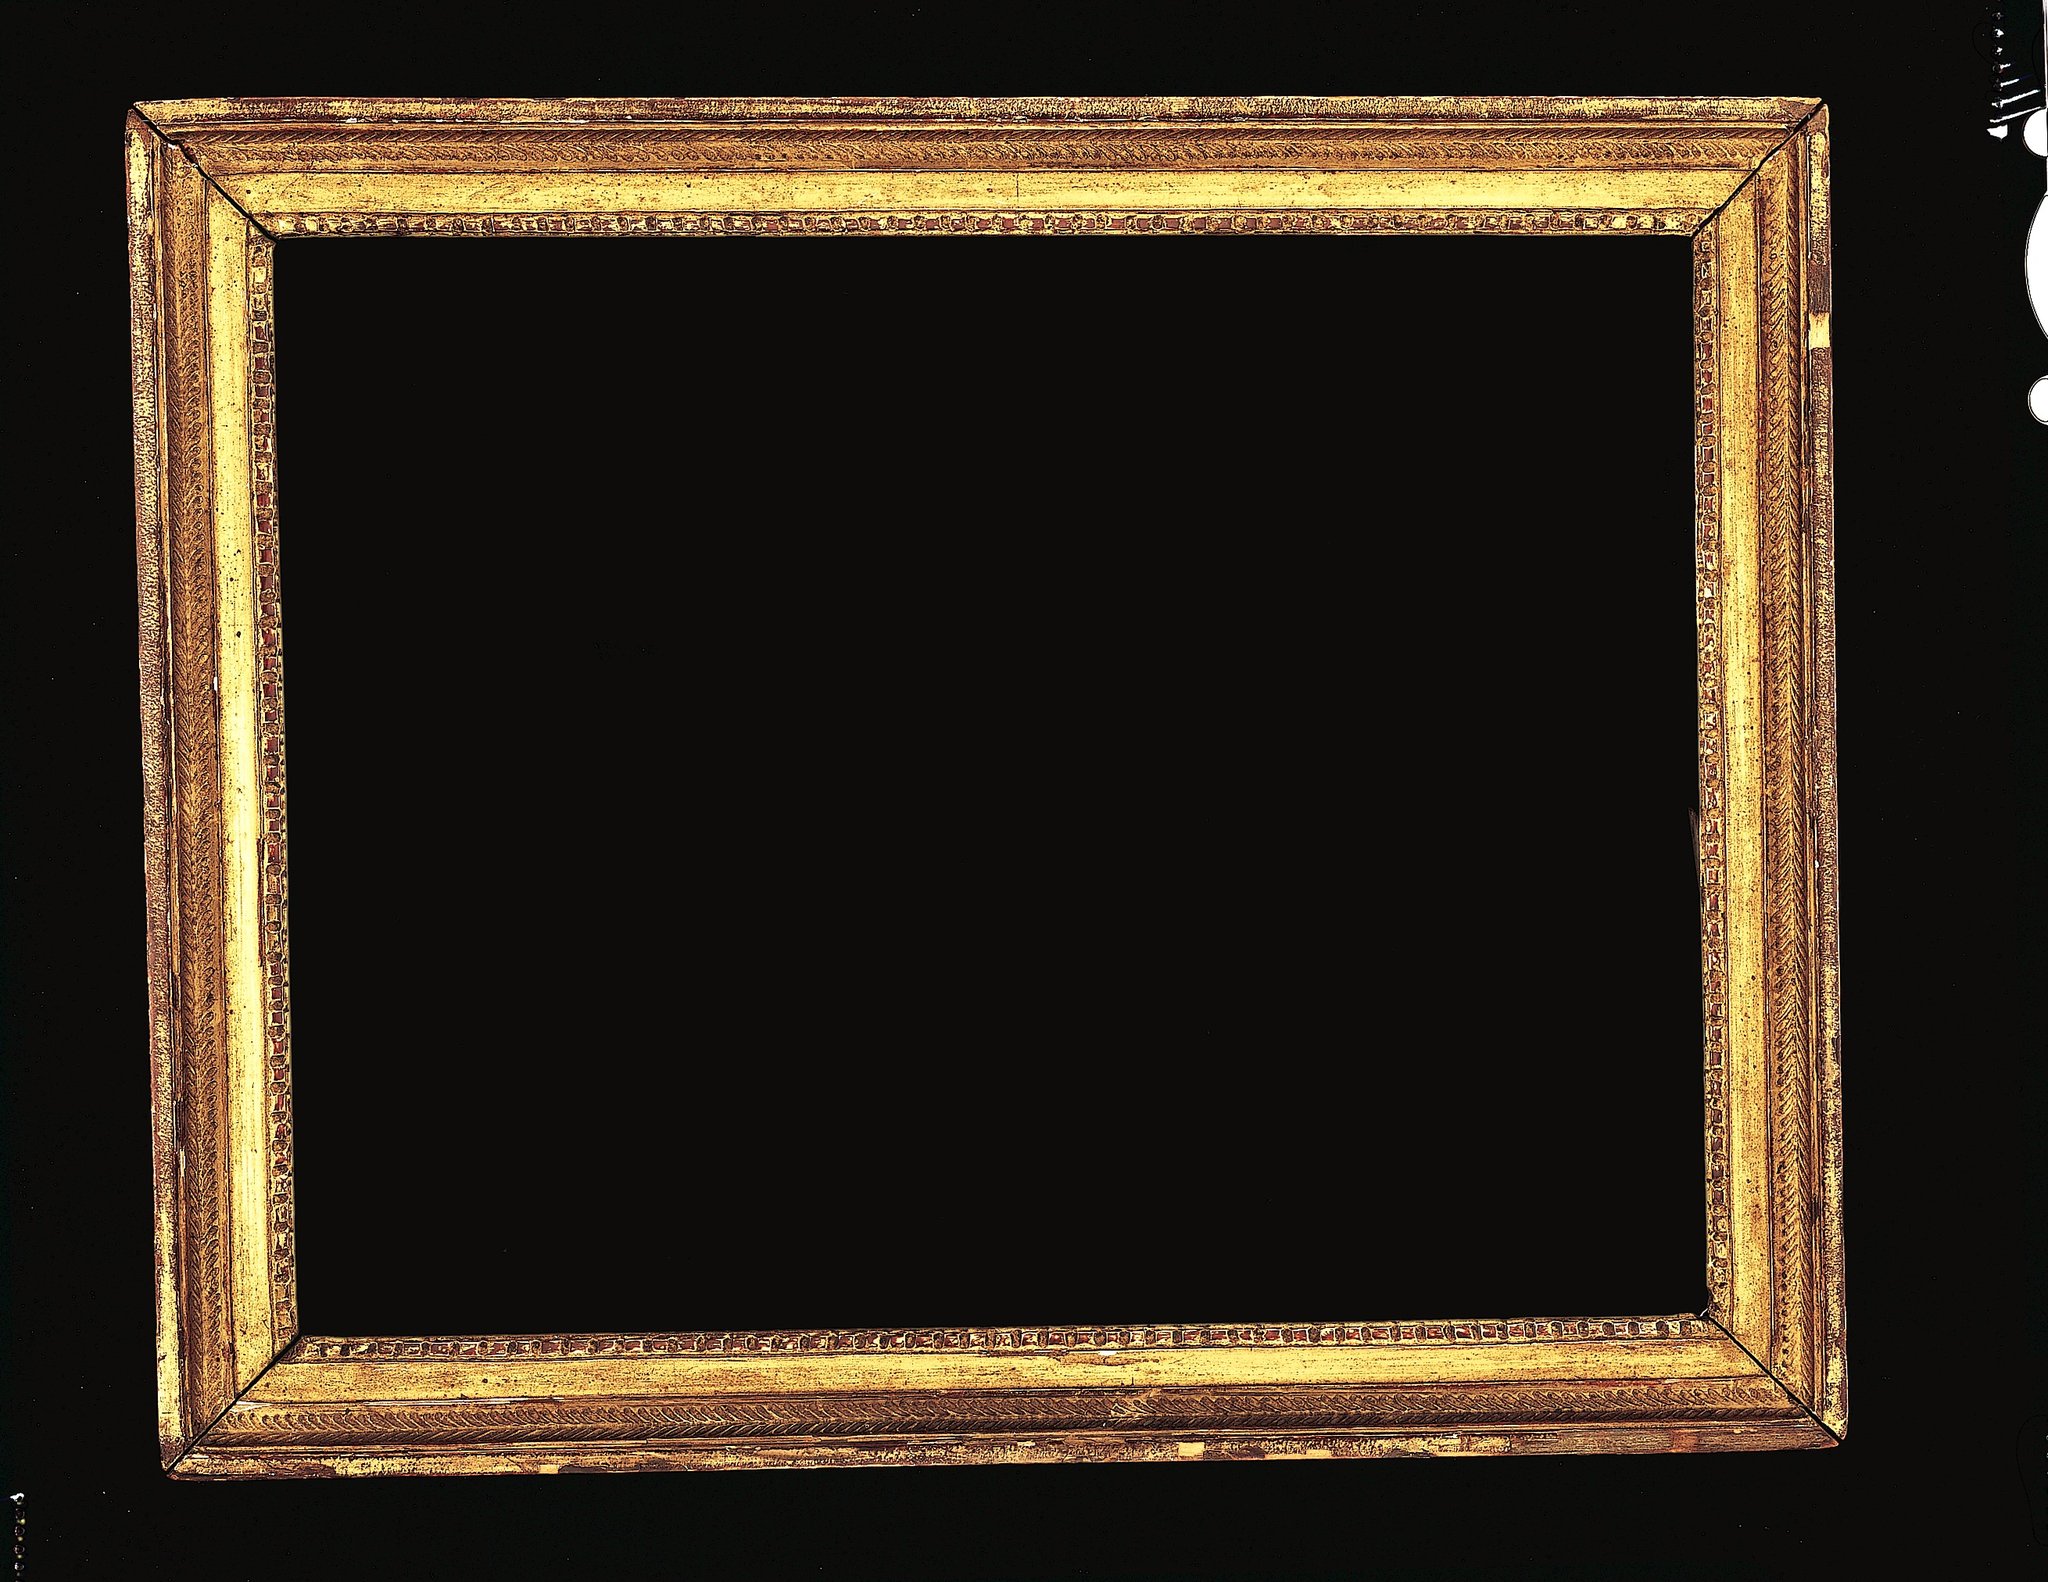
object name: frame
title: Cassetta frame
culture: french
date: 1770-1780